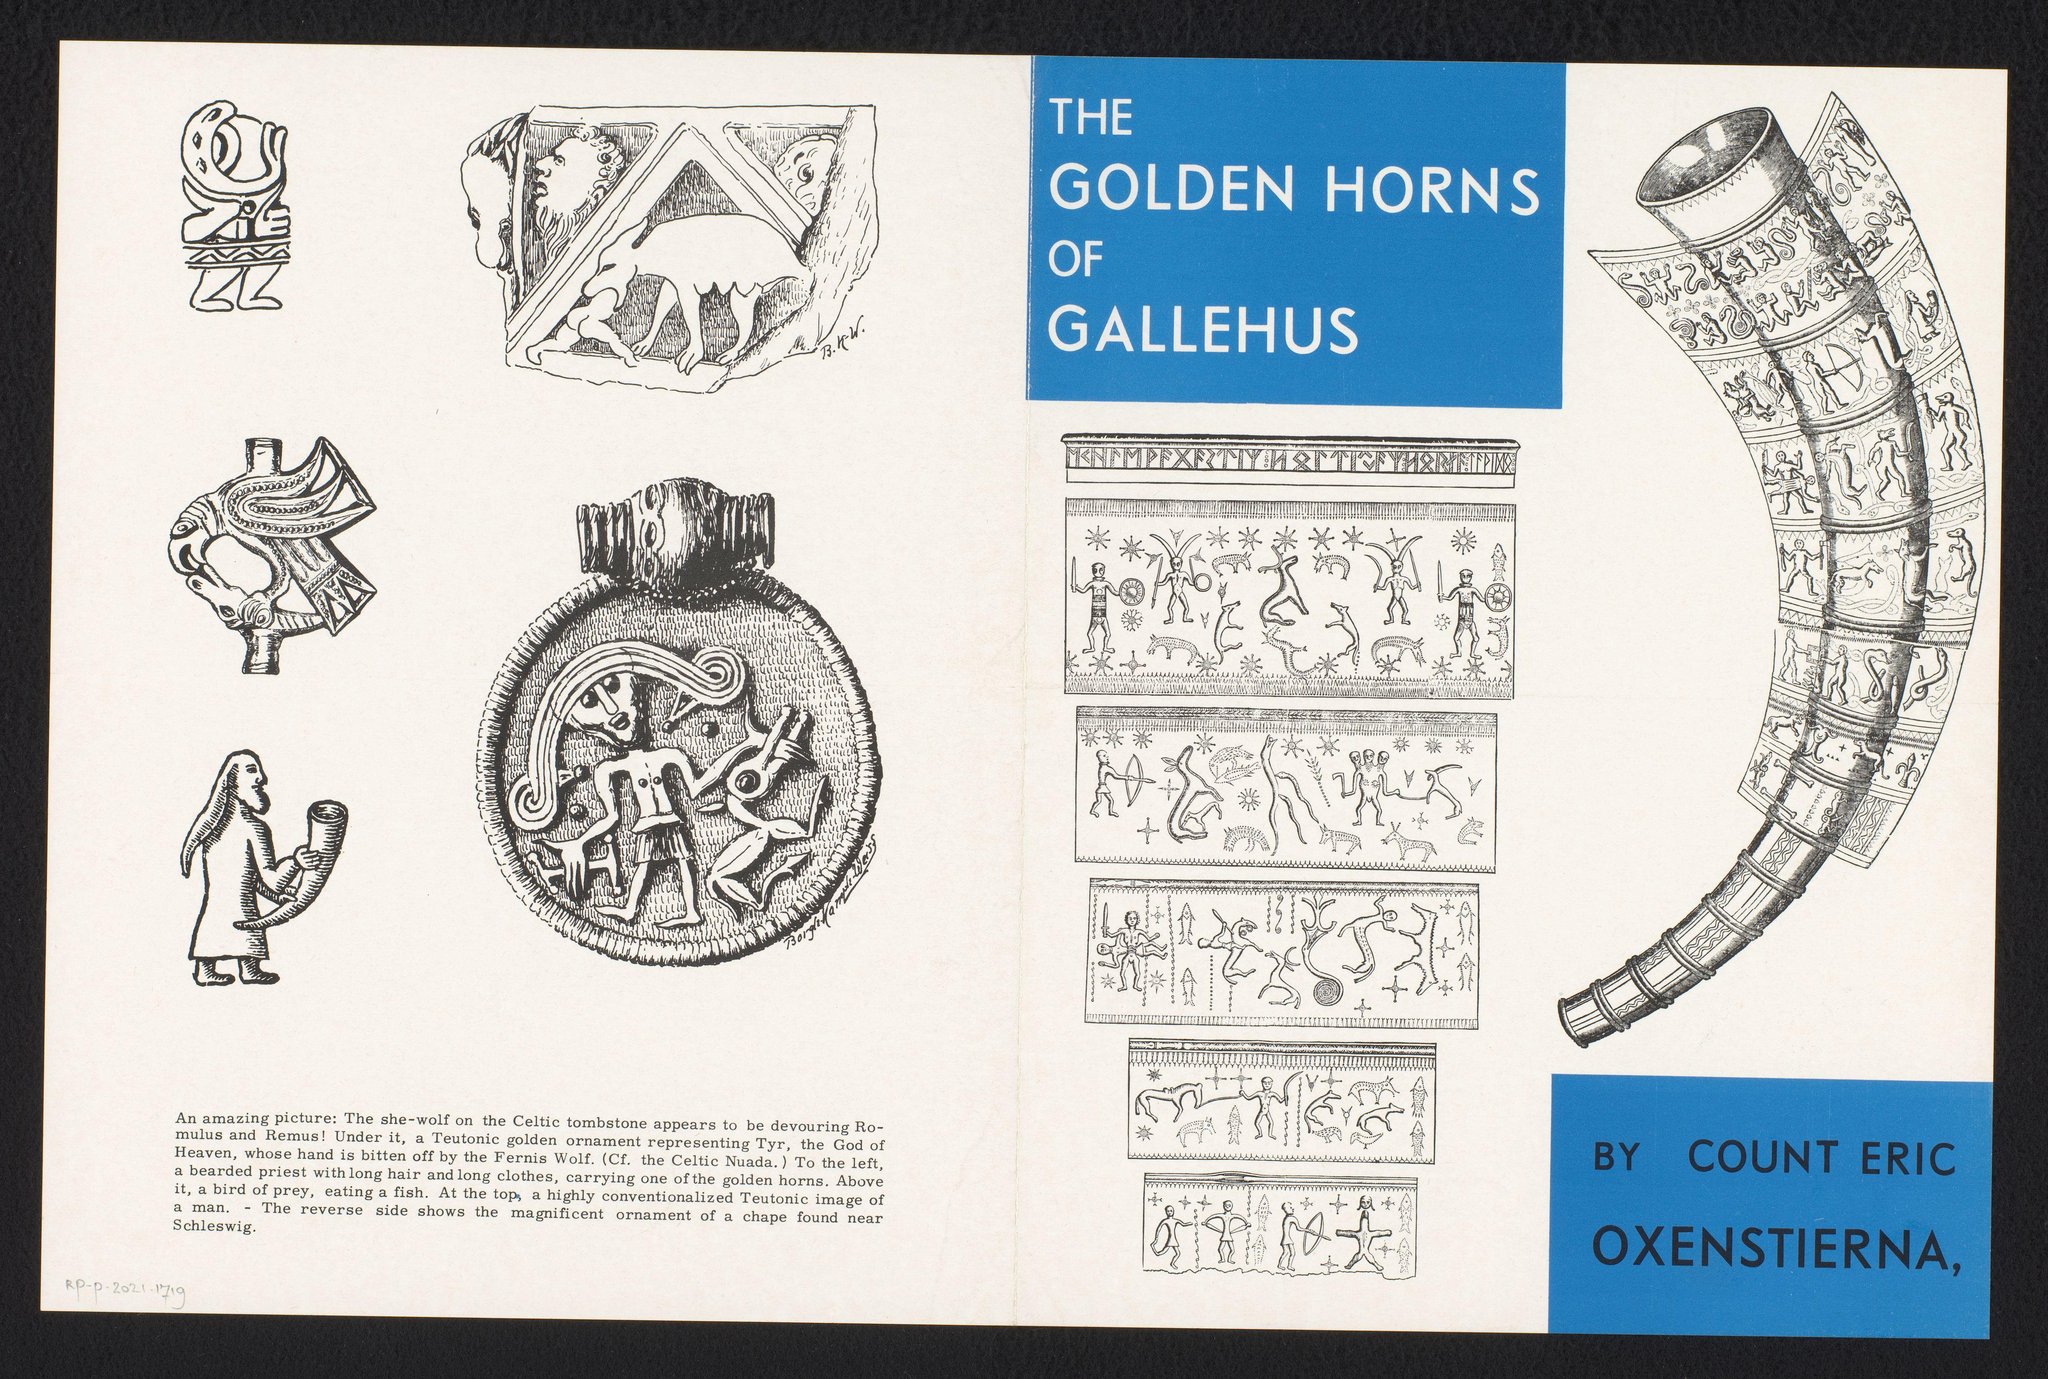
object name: prospectus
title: Prospectus voor: Eric Oxenstierna, The Golden Horns of Gallehus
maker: Anonymous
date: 1956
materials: paper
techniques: letterpress printing, printing block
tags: hunting horn, drinking-horn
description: Onduidelijk is of dit prospectus bedoeld was voor een Engelstalige editie van het boek van Eric Oxenstierna, of een Engelstalige aankondiging is van het boek dat in het Duits werd uitgegeven. Een Engelstalige editie is nooit gepubliceerd. De Duitstalige editie is: Oxenstierna, Eric. Die Goldhörner von Gallehus. Lidingo: [s.n.], 1956.